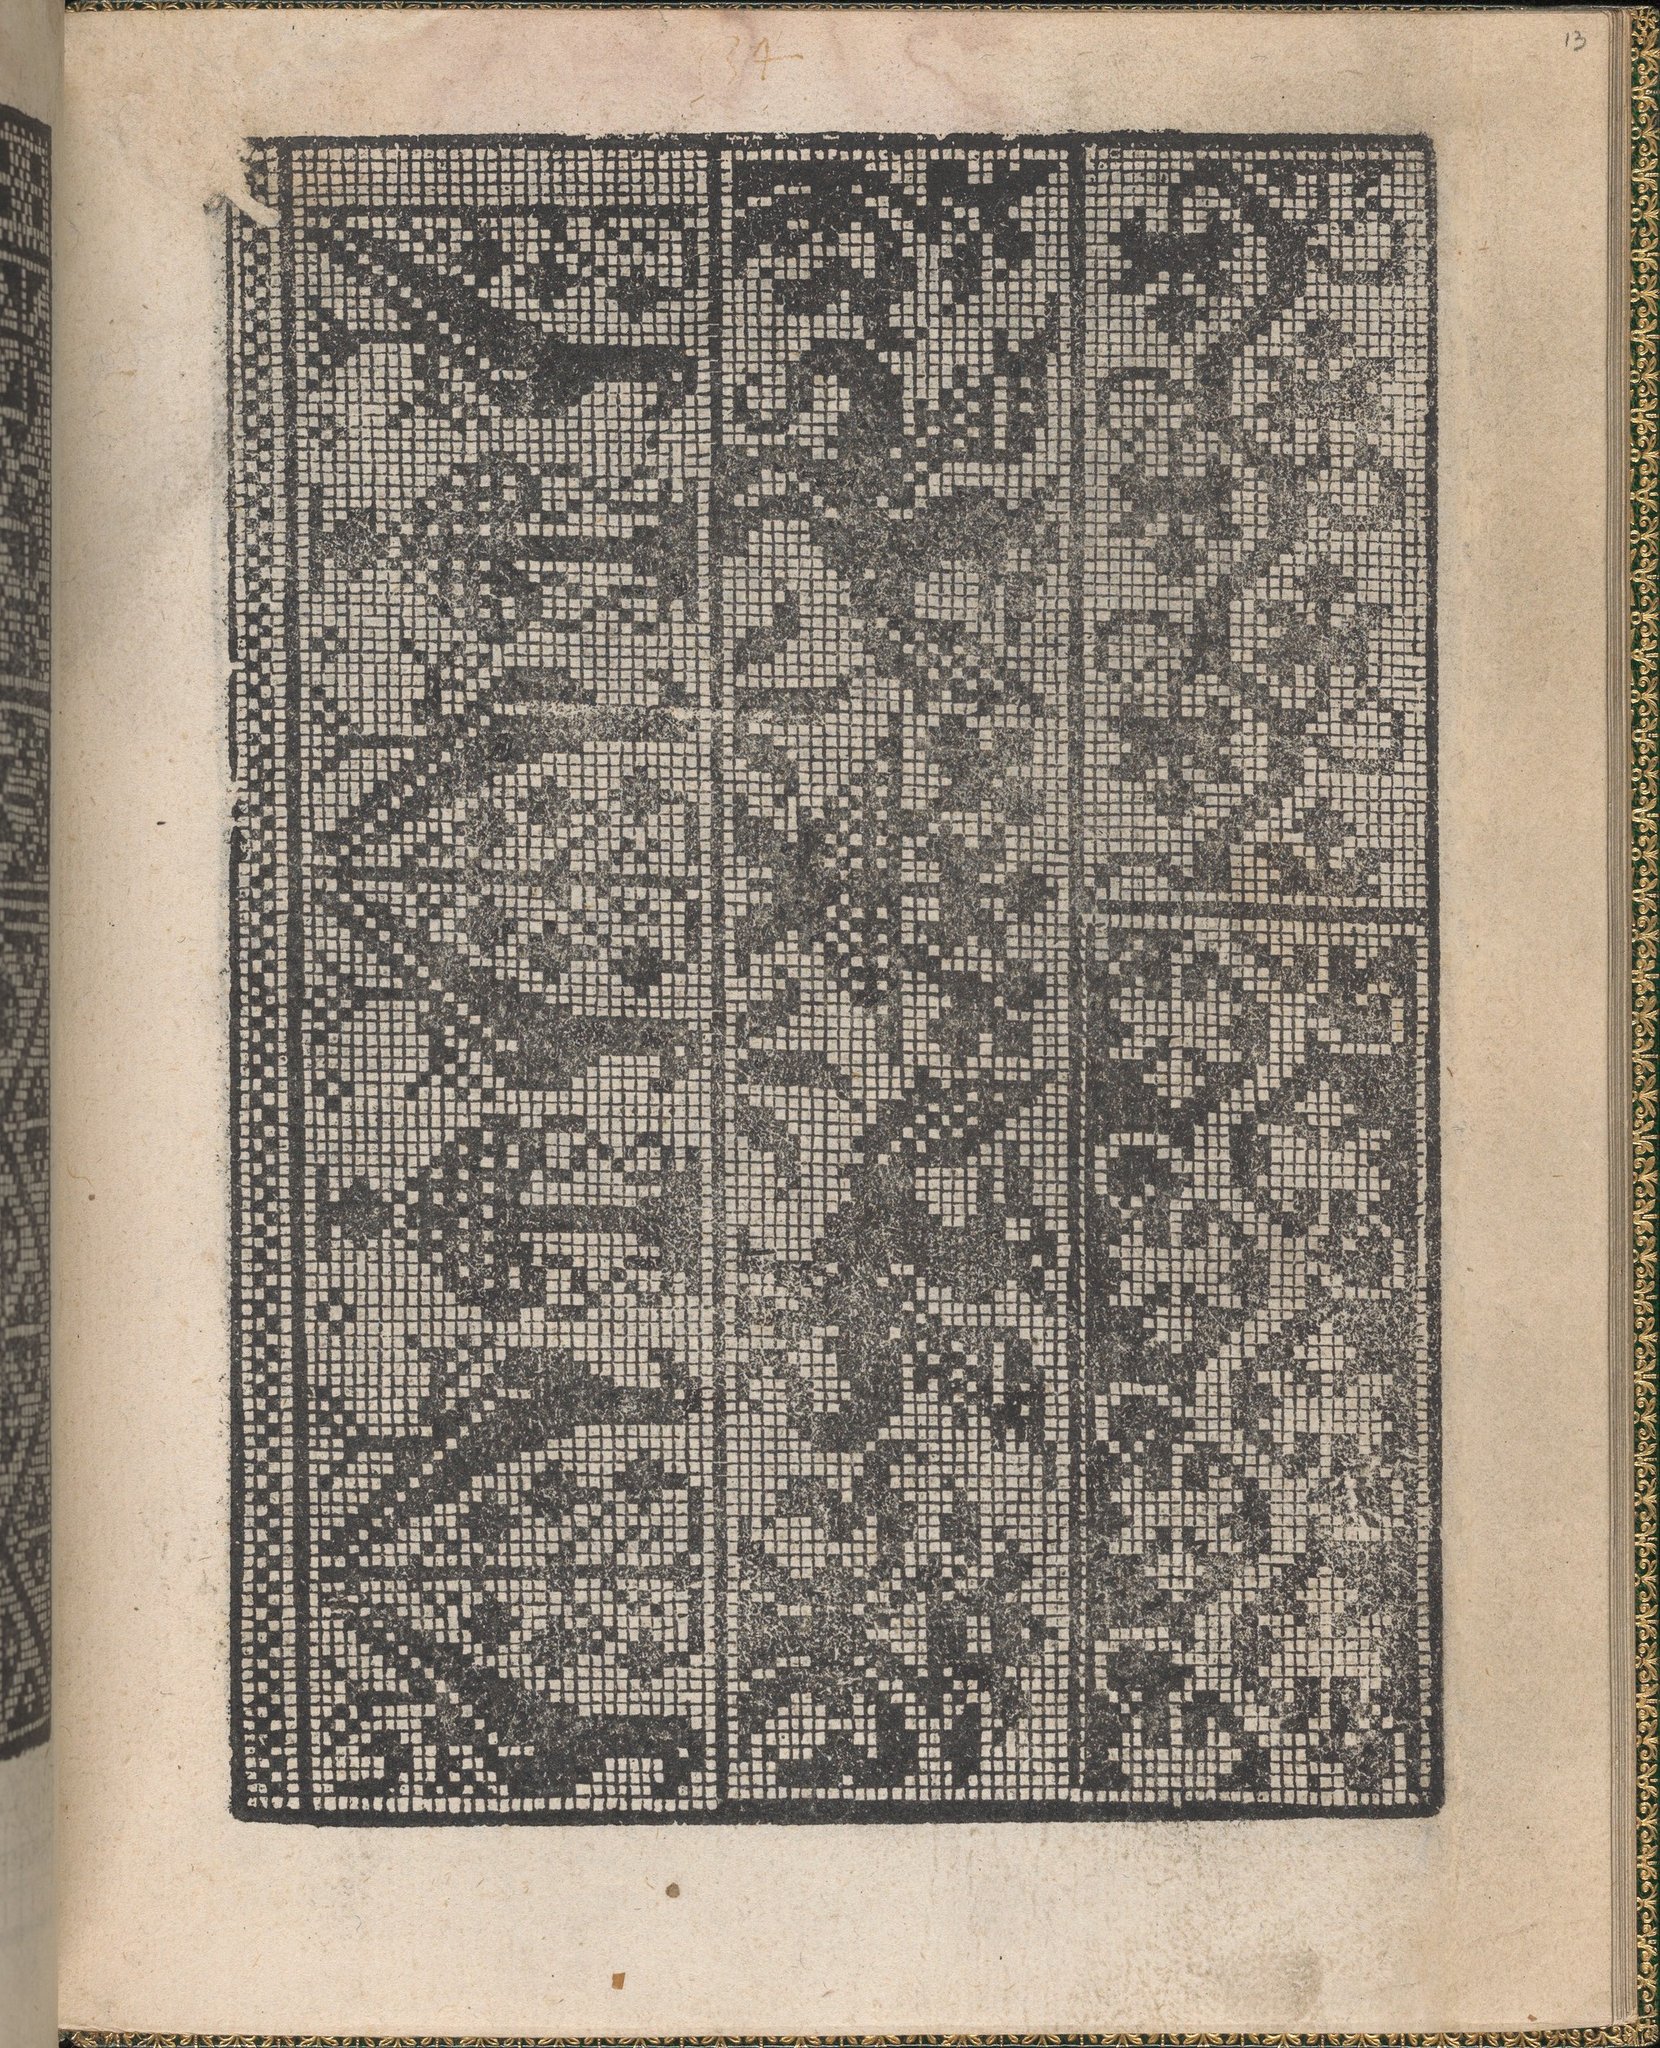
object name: book print ornament architecture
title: Ornamento delle belle & virtuose donne, page 7 (verso)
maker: matteo pagano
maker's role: publisher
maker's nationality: italian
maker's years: 1515-1588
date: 1554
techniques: woodcut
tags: birds,ornament